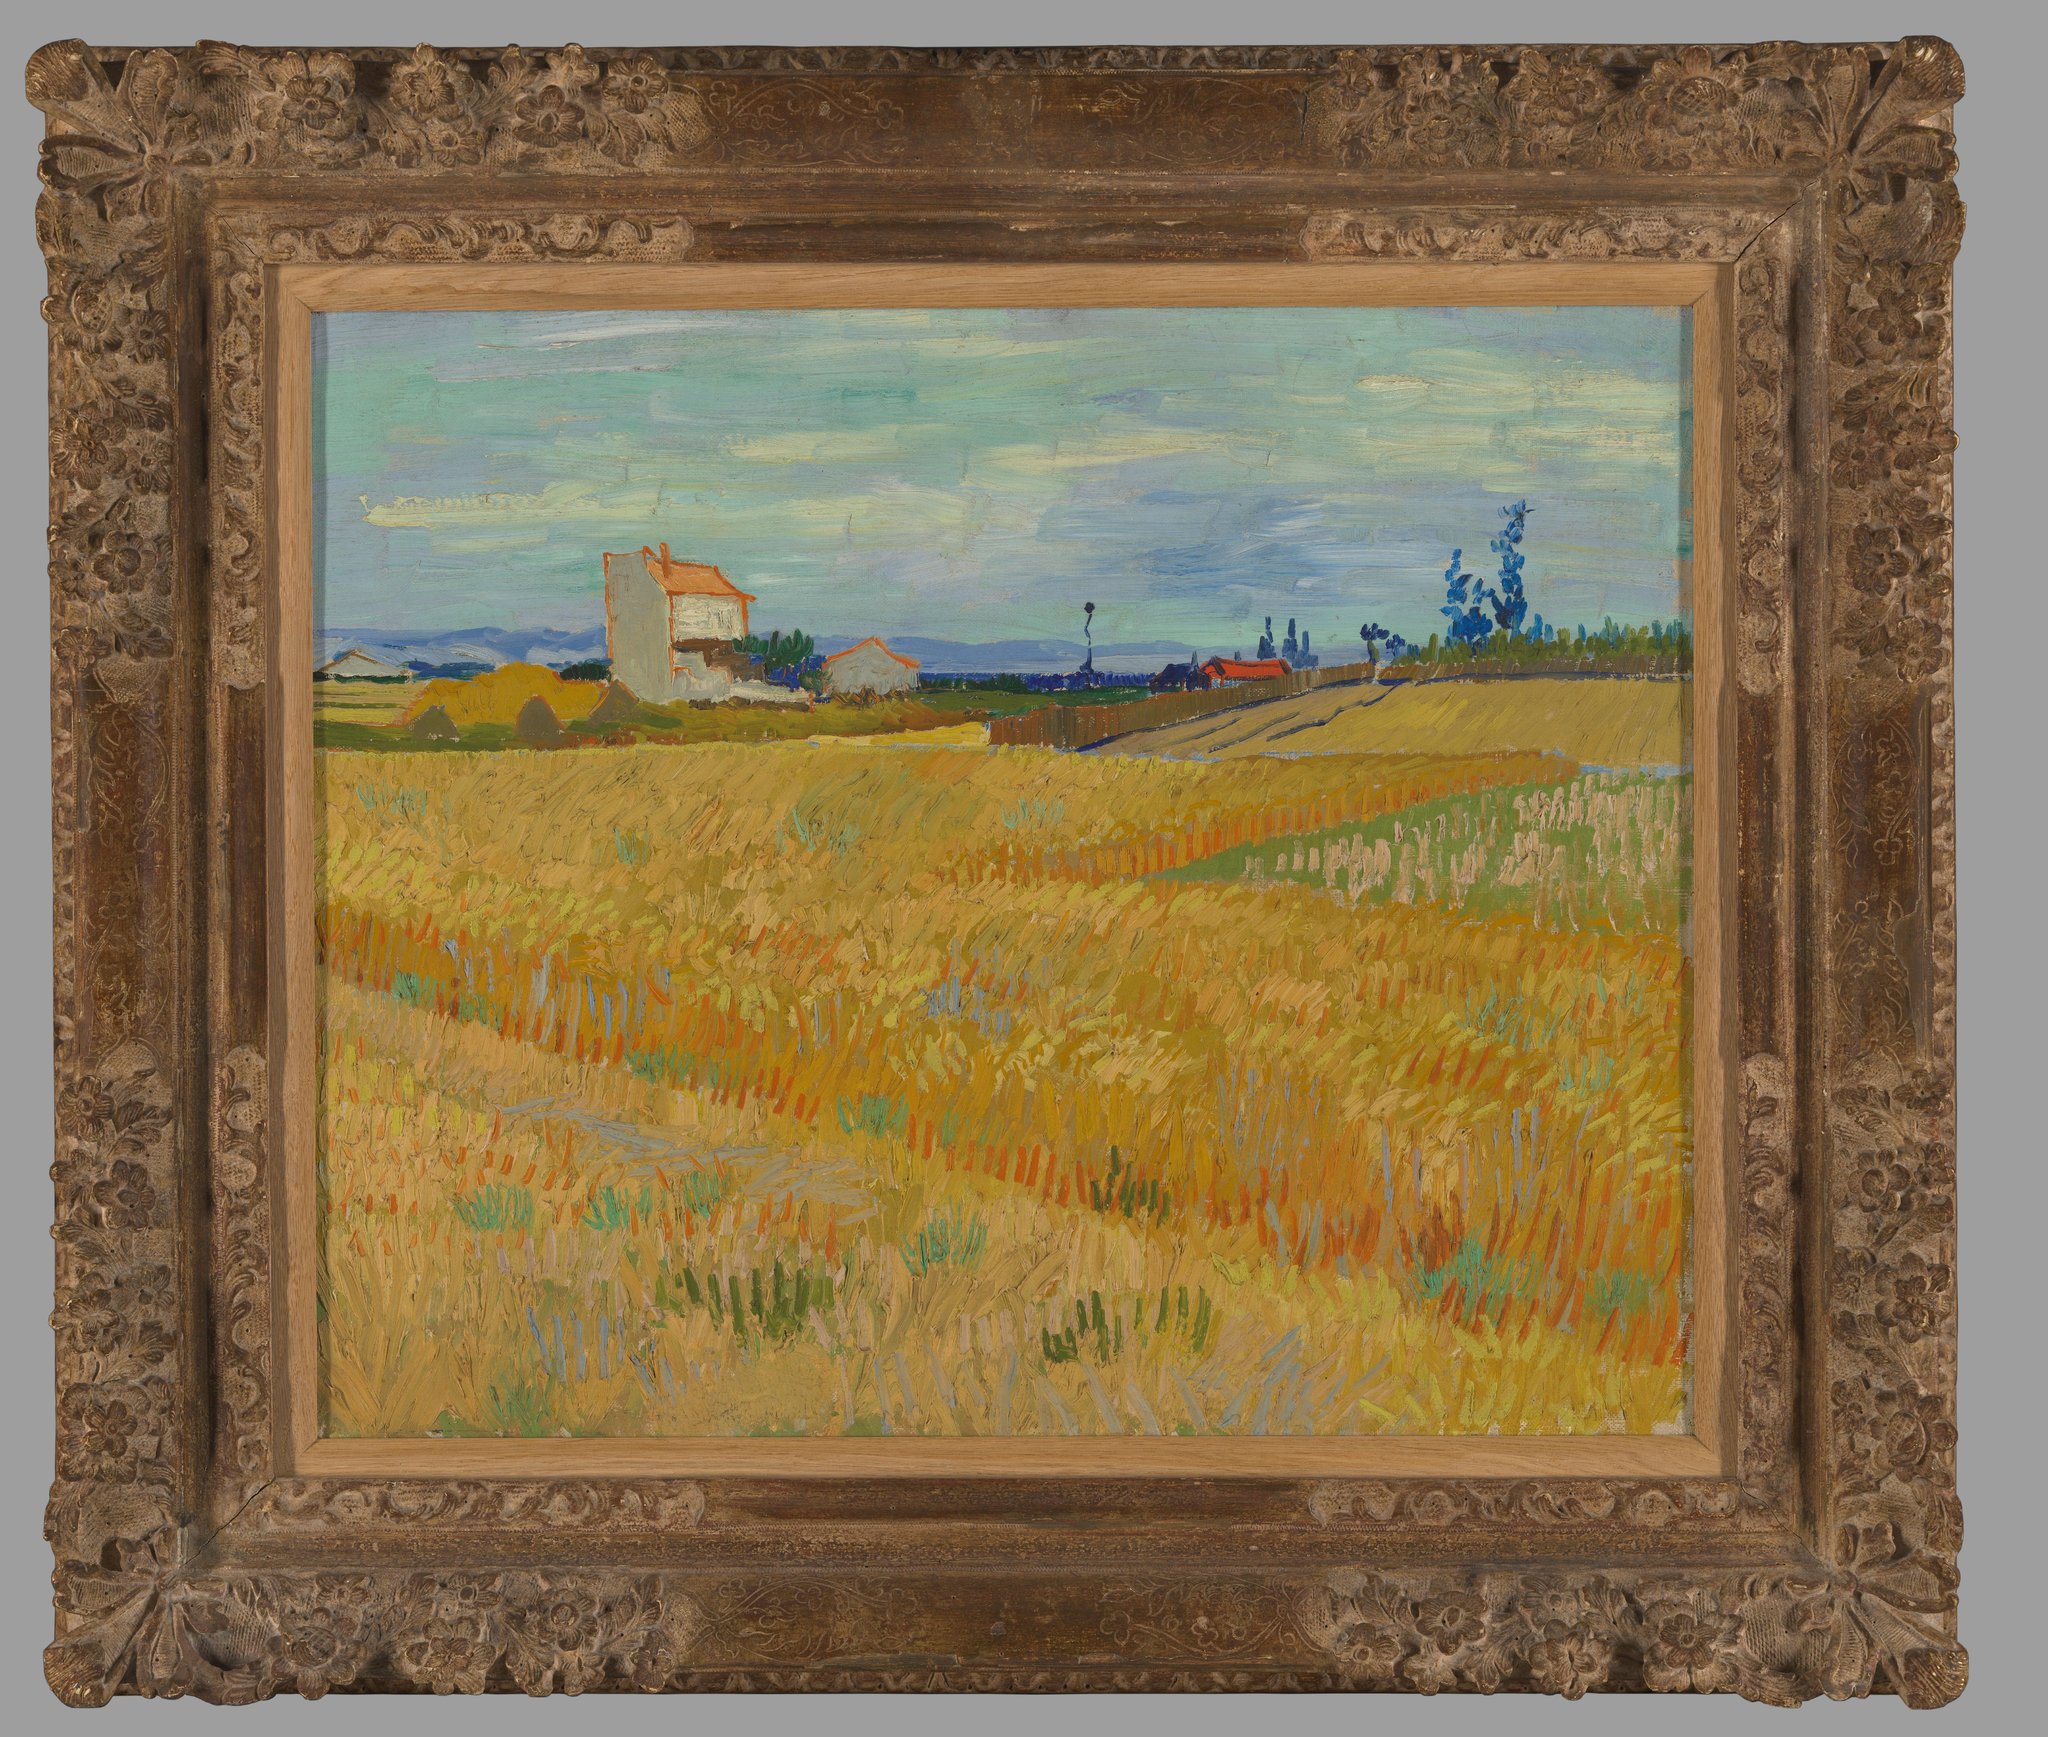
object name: painting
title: Wheatfield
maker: vincent van gogh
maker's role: draughtsman, painter, print maker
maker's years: 1853-1890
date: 1888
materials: canvas, oil, paint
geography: arles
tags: arles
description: In 1888, Paris became too busy for Van Gogh, and in the spring he left for Arles. He was captivated by the vibrant colours of the landscape in the south of France. The yellow of the wheat takes centre stage here, thanks to the high horizon. Van Gogh further intensified the blue of the mountains and the sky to enhance the colour contrast with that yellow.